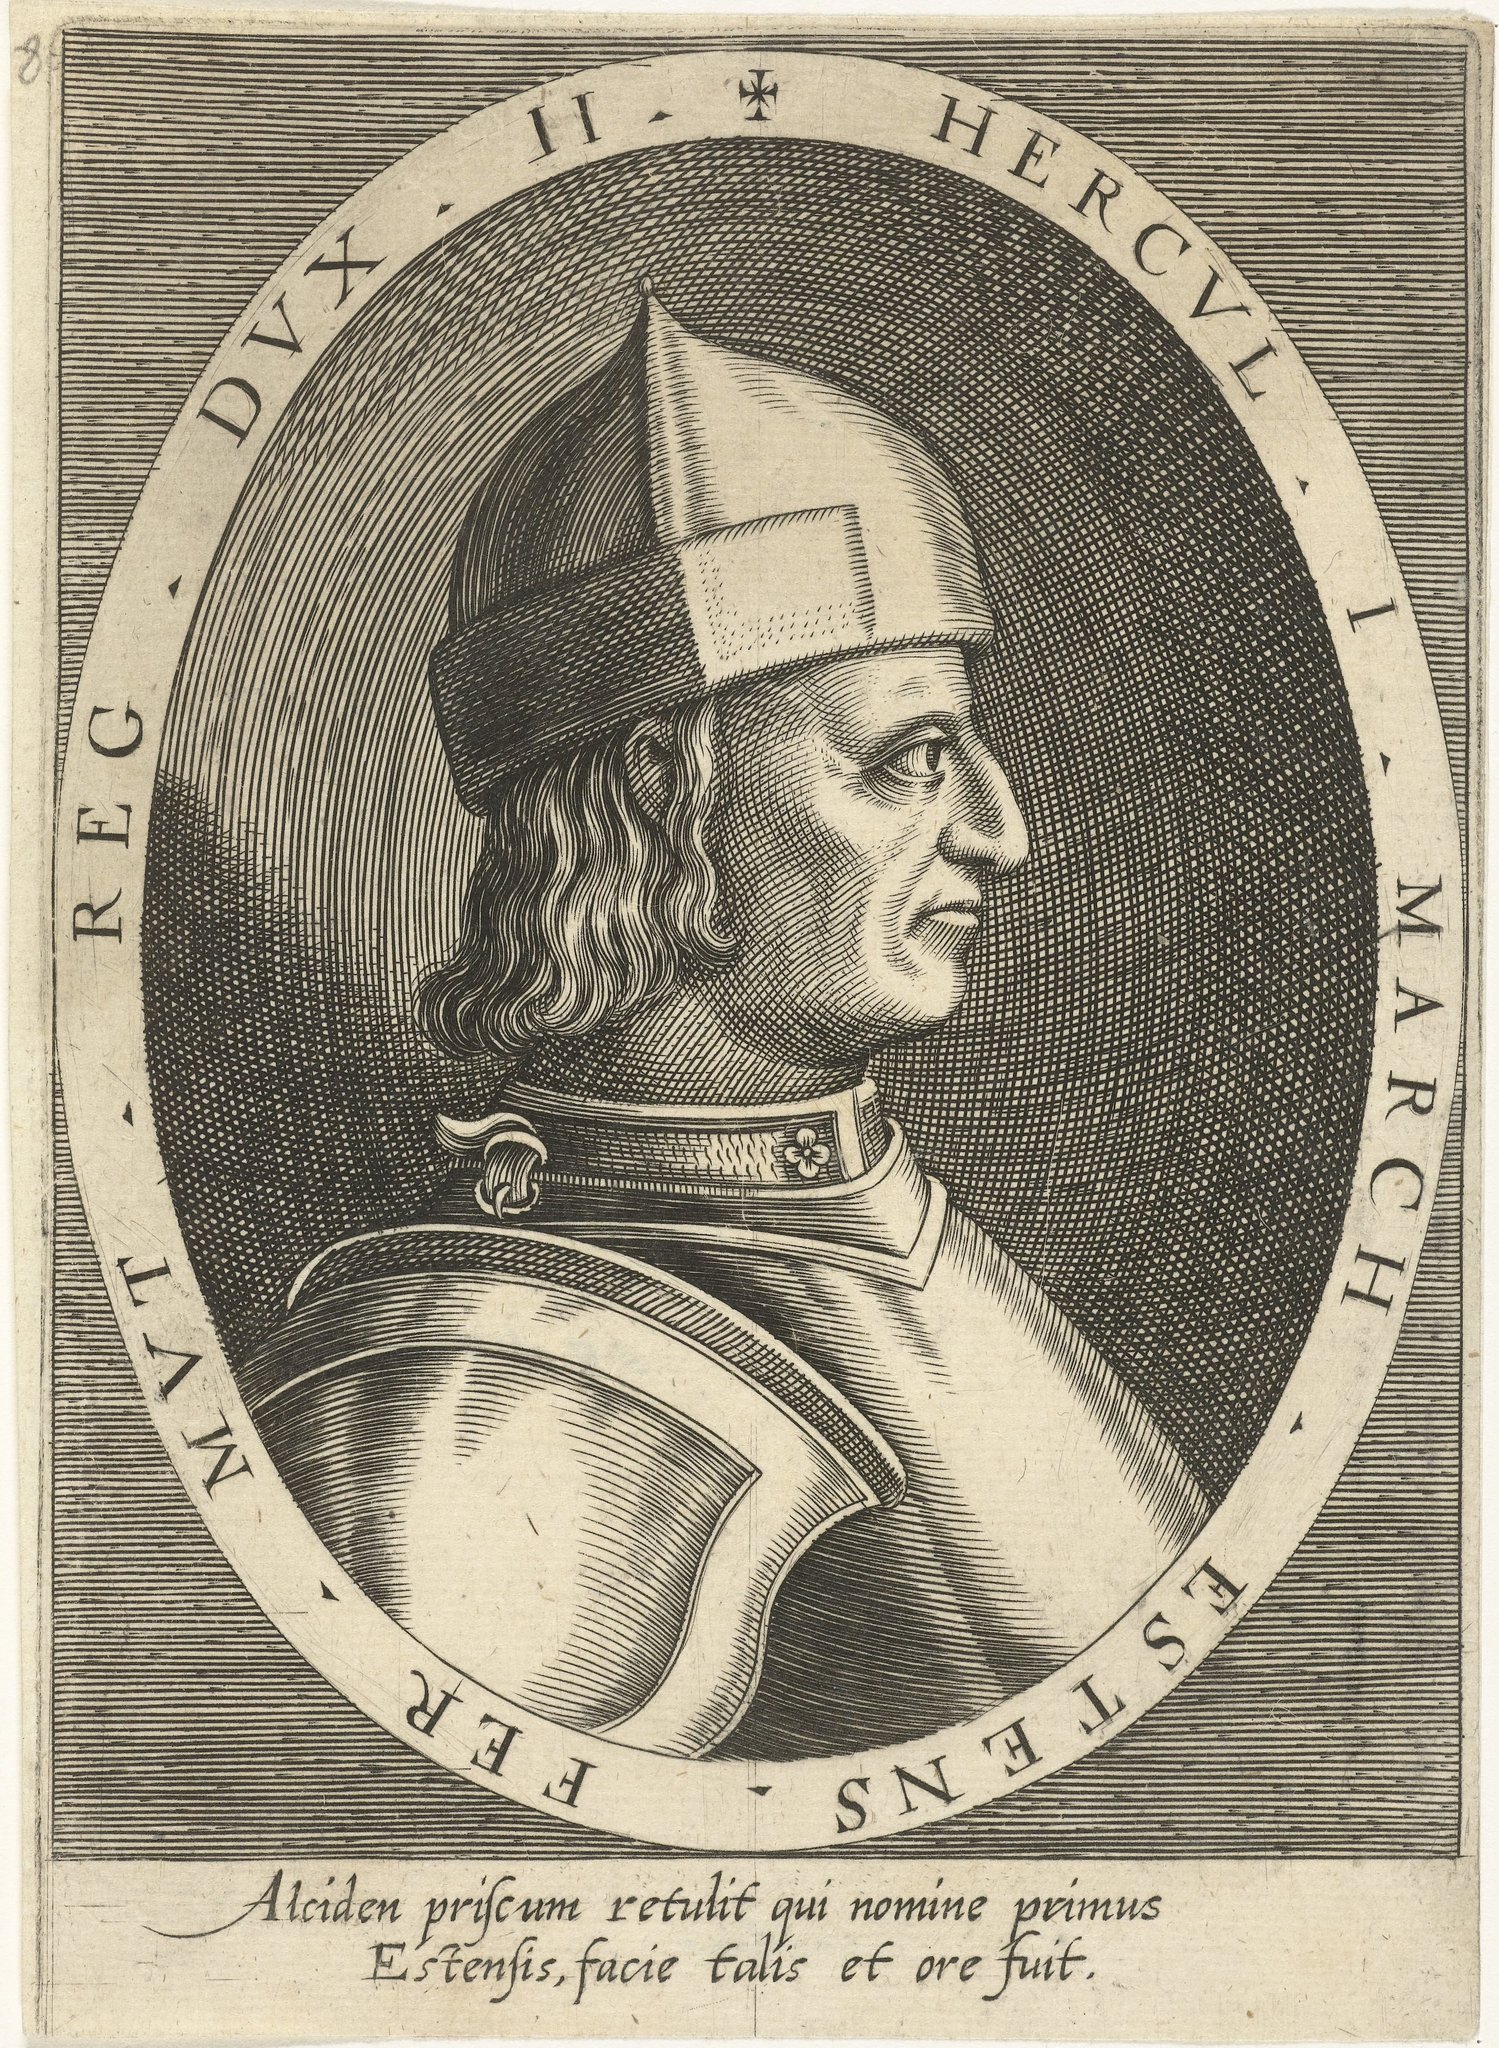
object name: print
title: Portretten van bekende personen uit de zestiende eeuw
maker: dominicus custos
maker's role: print maker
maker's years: 1560-1615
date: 1600-1604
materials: paper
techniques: engraving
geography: augsburg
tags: ferrara (stad), ercole i d'este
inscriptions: collector's mark: Lugt 2228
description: Illustratie uit: D. Custos en M. Henning. Atrium heroicum Caesarum, regum aliorq. summatum ac procerum qui intra proximum seculum vixere, aut hodie supersunt, imaginib. Deel 1-4. Augsburg: D. Custos, 1600-1604.